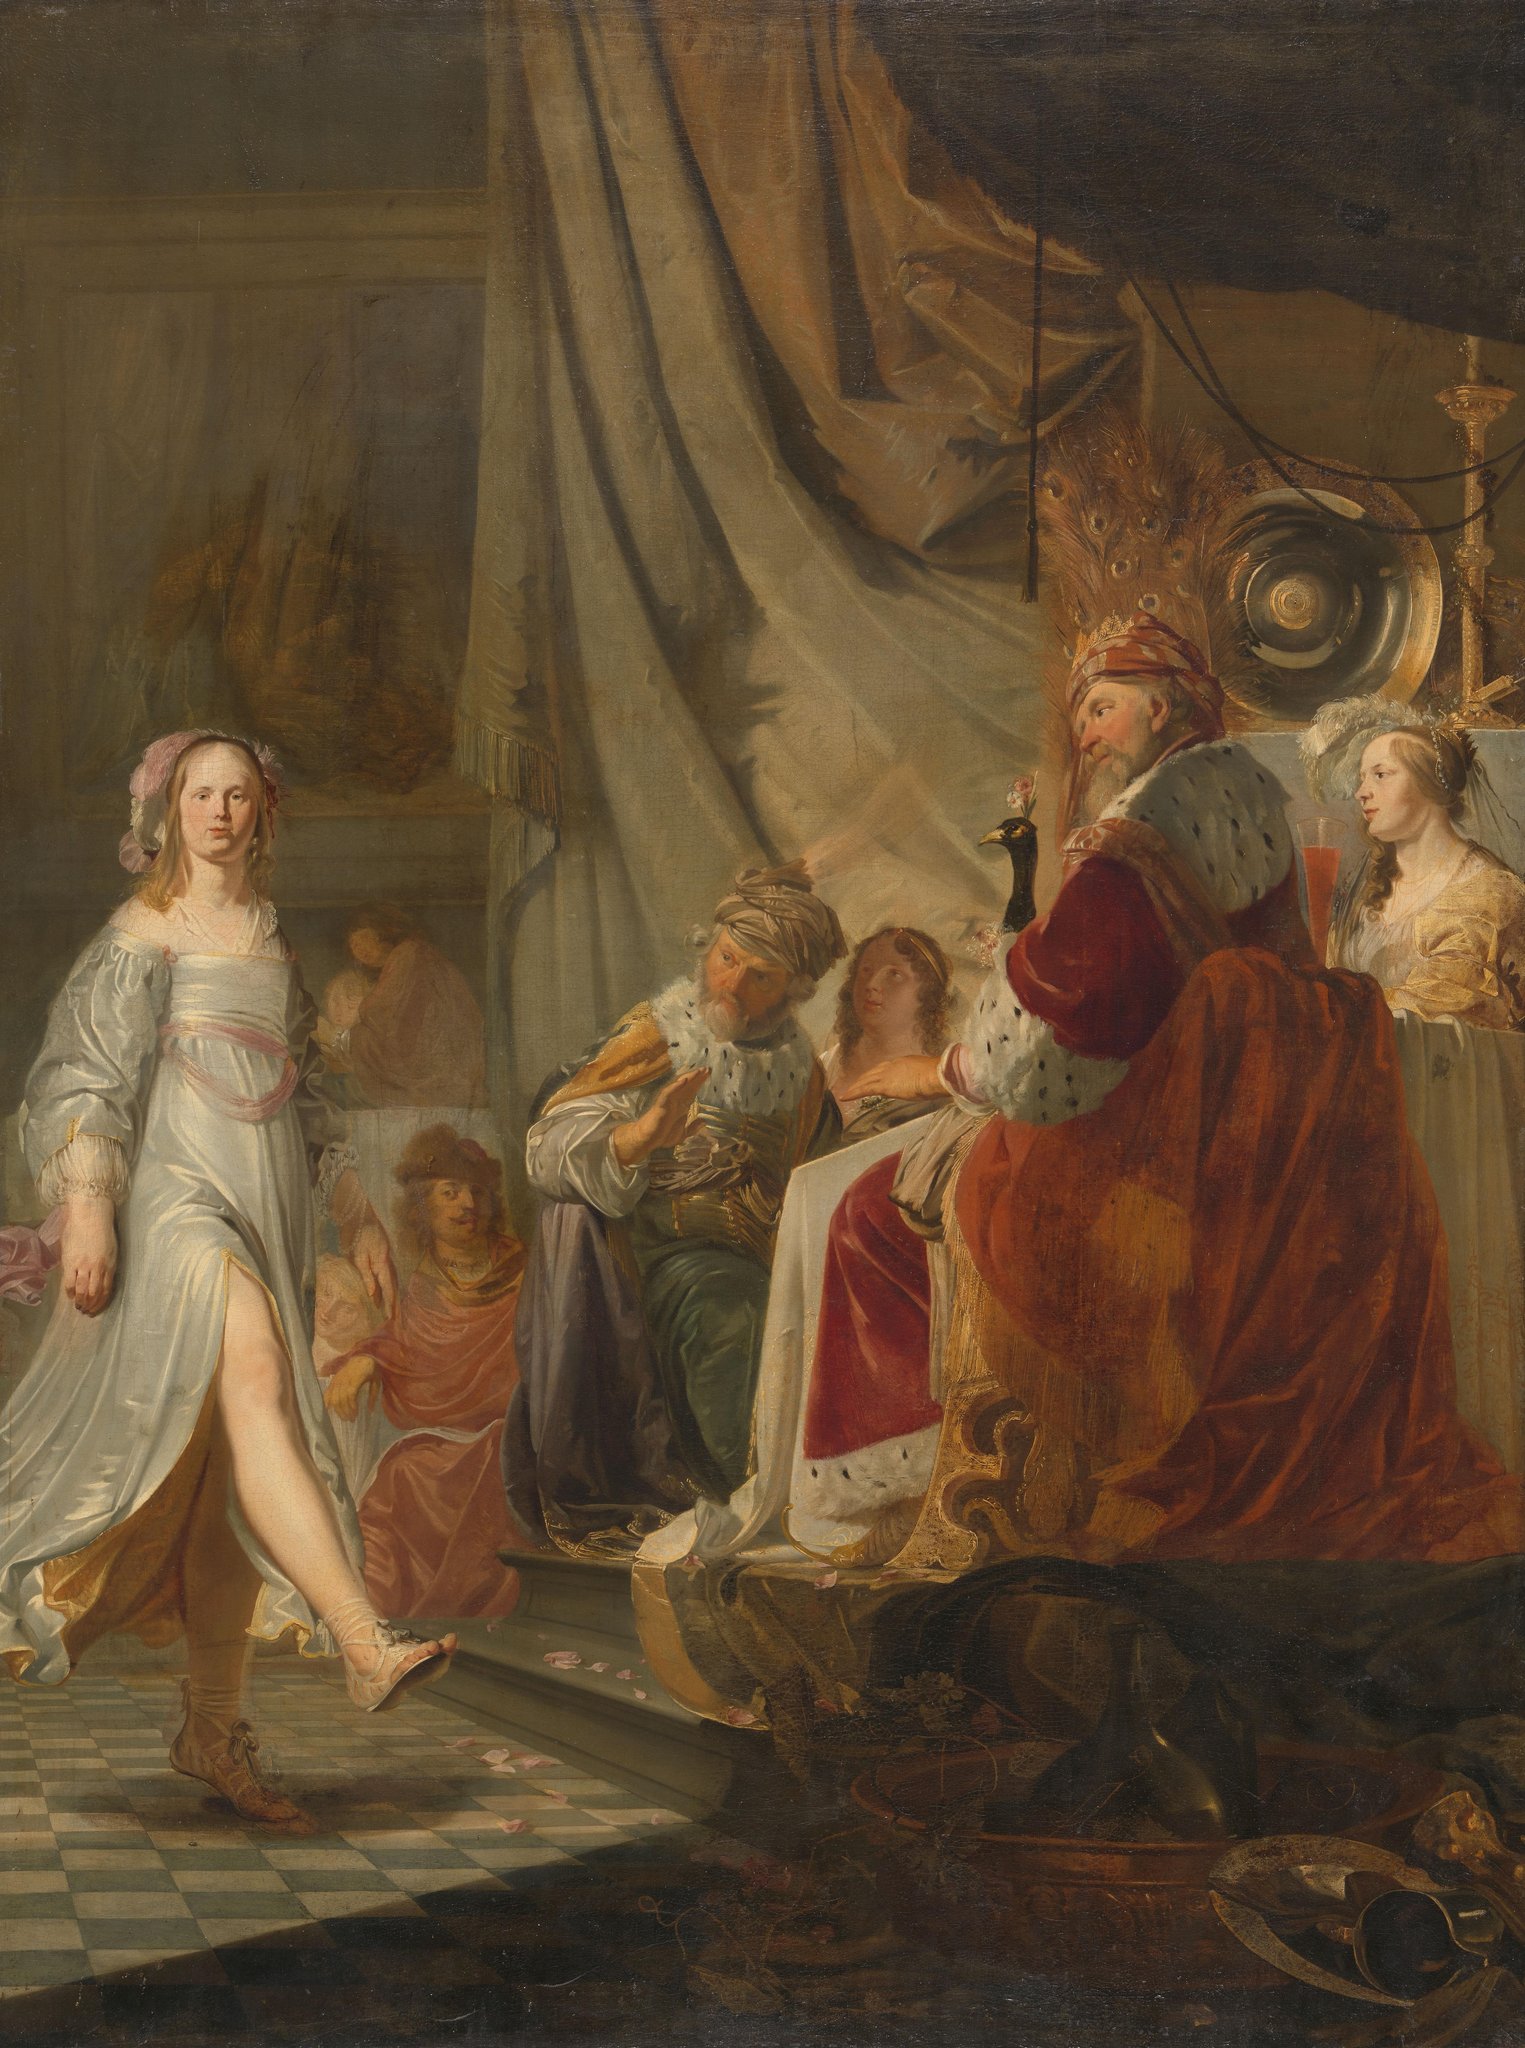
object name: painting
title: Salome Dancing for Herod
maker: hans horions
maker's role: painter, print maker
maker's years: 1624-1672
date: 1634-1672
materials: canvas, oil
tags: woman dancing alone, salome dancing during the banquet of herod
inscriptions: signature (false): ‘F. Bol f. 16..’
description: Salome dansend voor koning Herodes. De koning zit rechts met enkele anderen aan een tafel waarop een pauwenpastei staat. Tegen de wand en rechts op de voorgrond staat siervaatwerk.